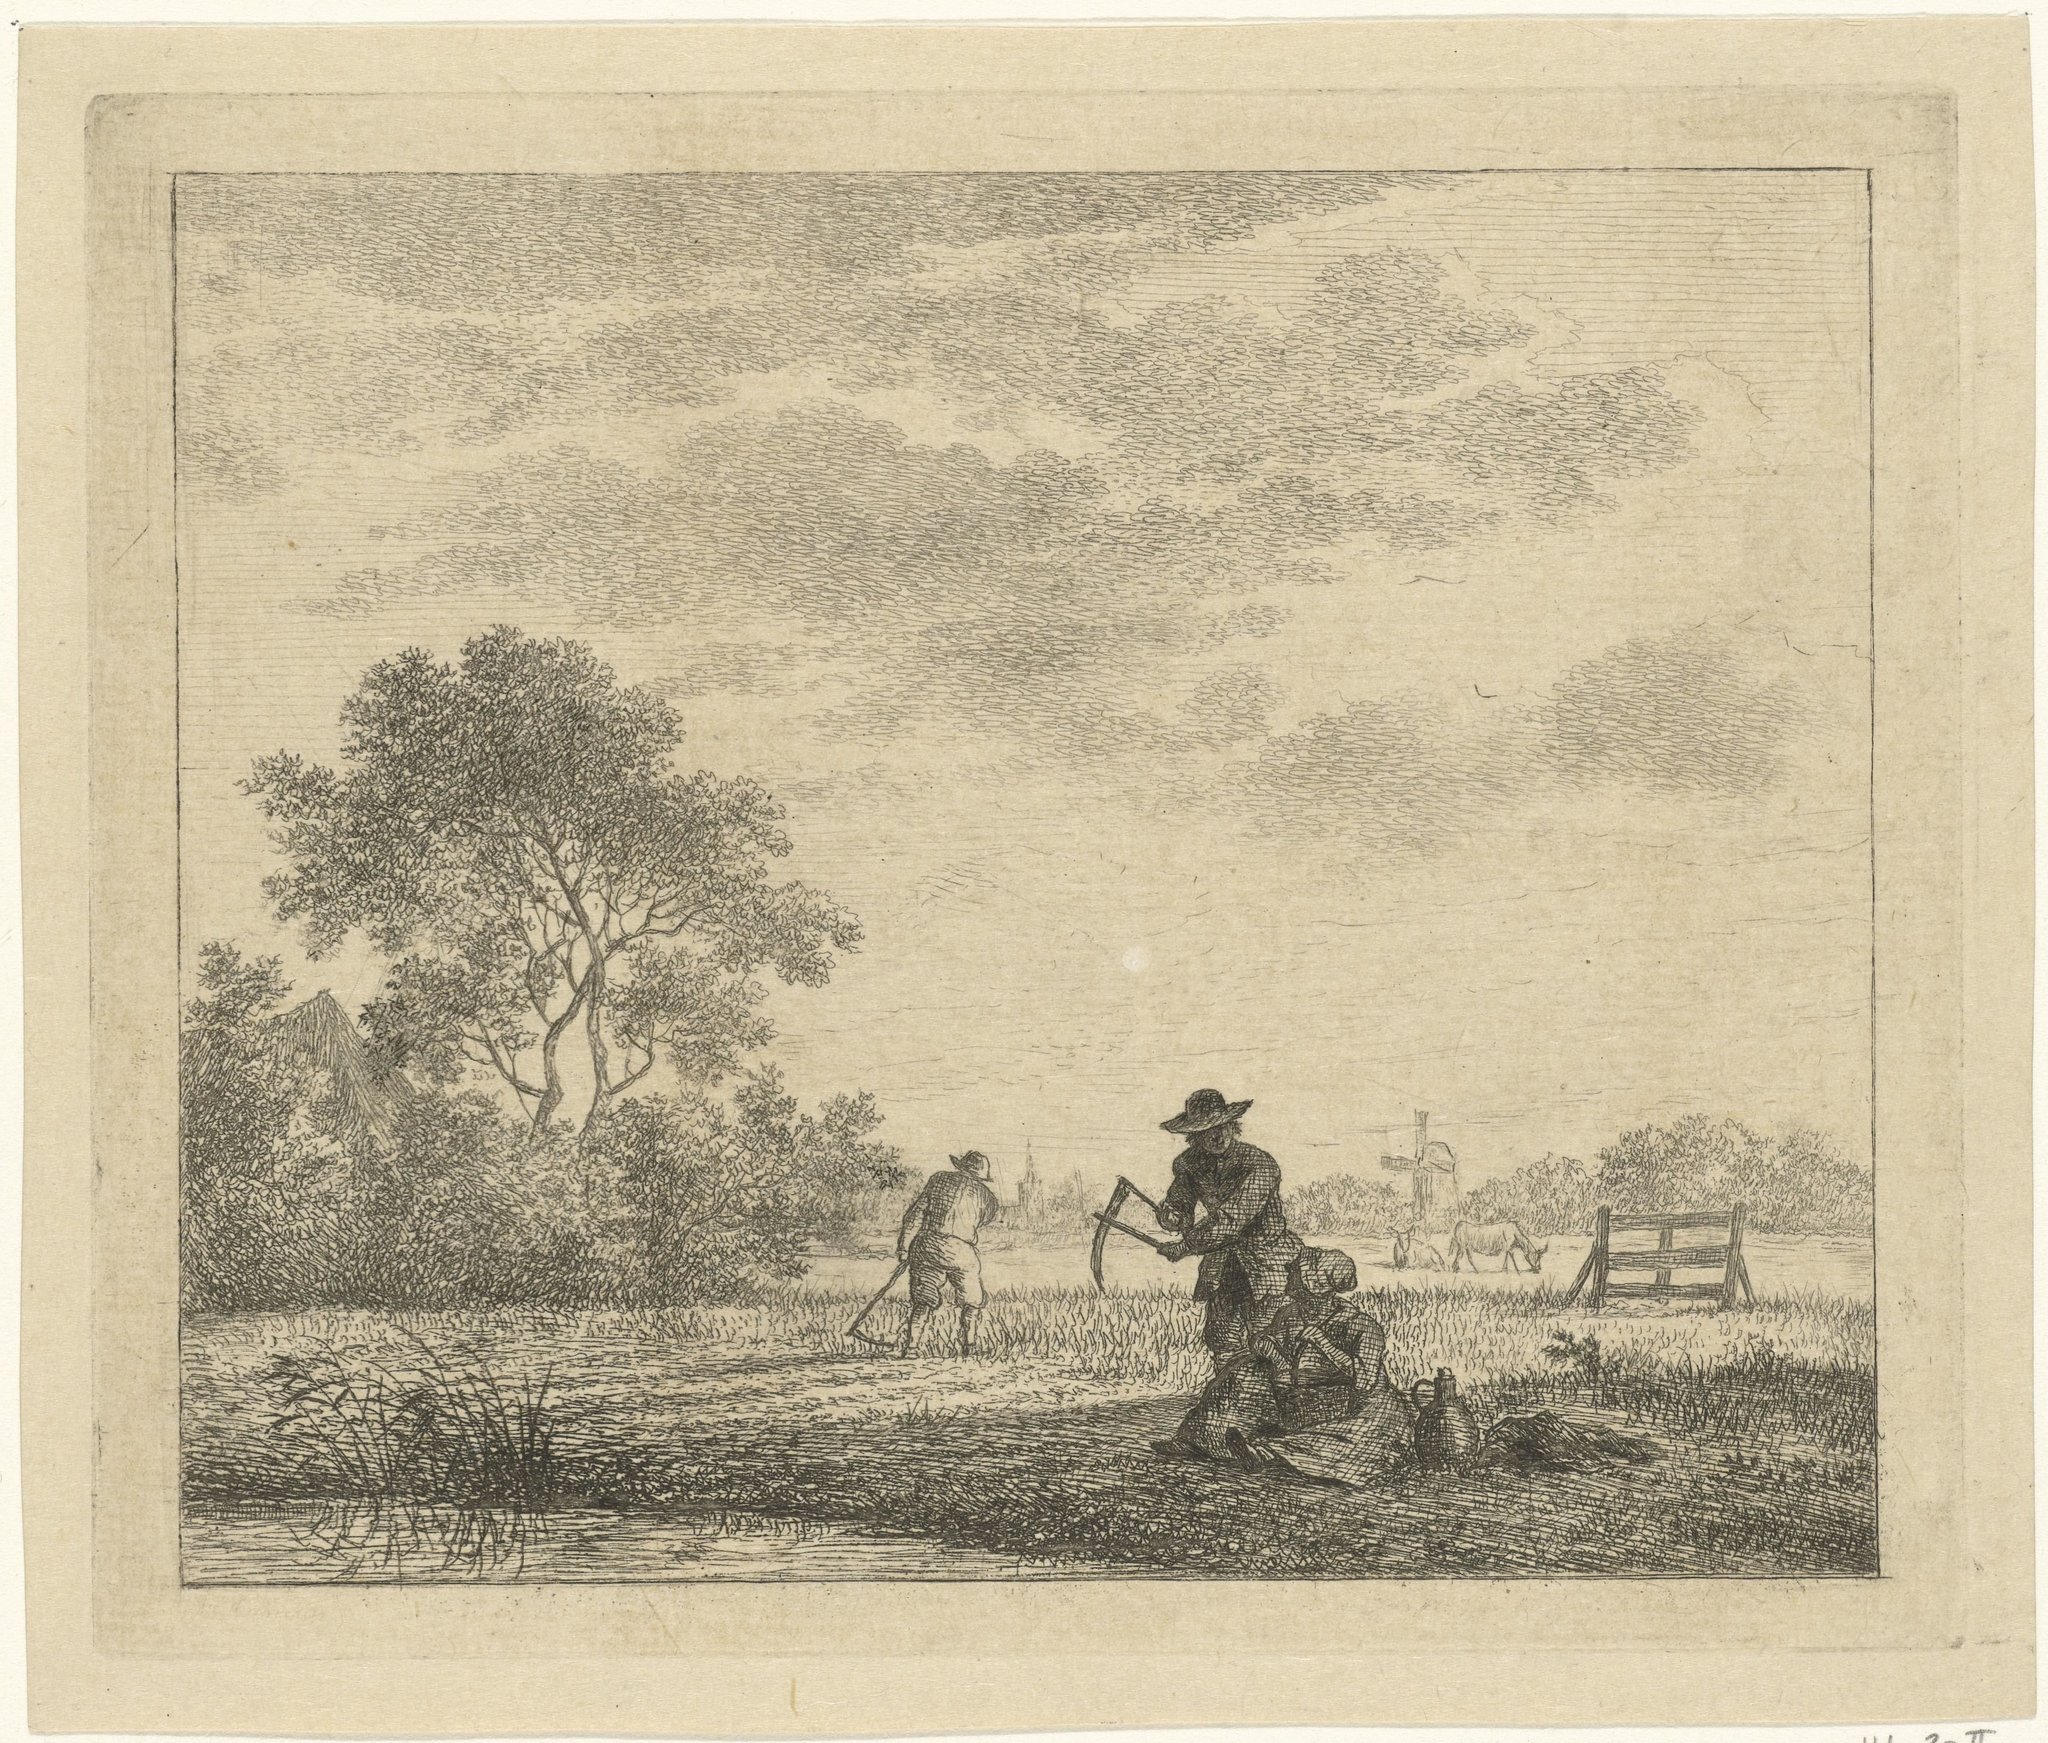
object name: print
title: De gecouleurde Teekeningen van de 12 Maanden (...)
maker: johannes janson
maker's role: draughtsman, painter, print maker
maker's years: 1729-1784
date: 1783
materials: paper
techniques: etching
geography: leiden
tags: agricultural implements: scythe, landscape symbolizing june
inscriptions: collector's mark: Lugt 240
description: Landschap met een zittende boerin en twee boeren die een akker bewerken met een zeis. Op de achtergrond twee koeien, een kerk en een molen. Zevende prent uit een serie van dertien met maanden.